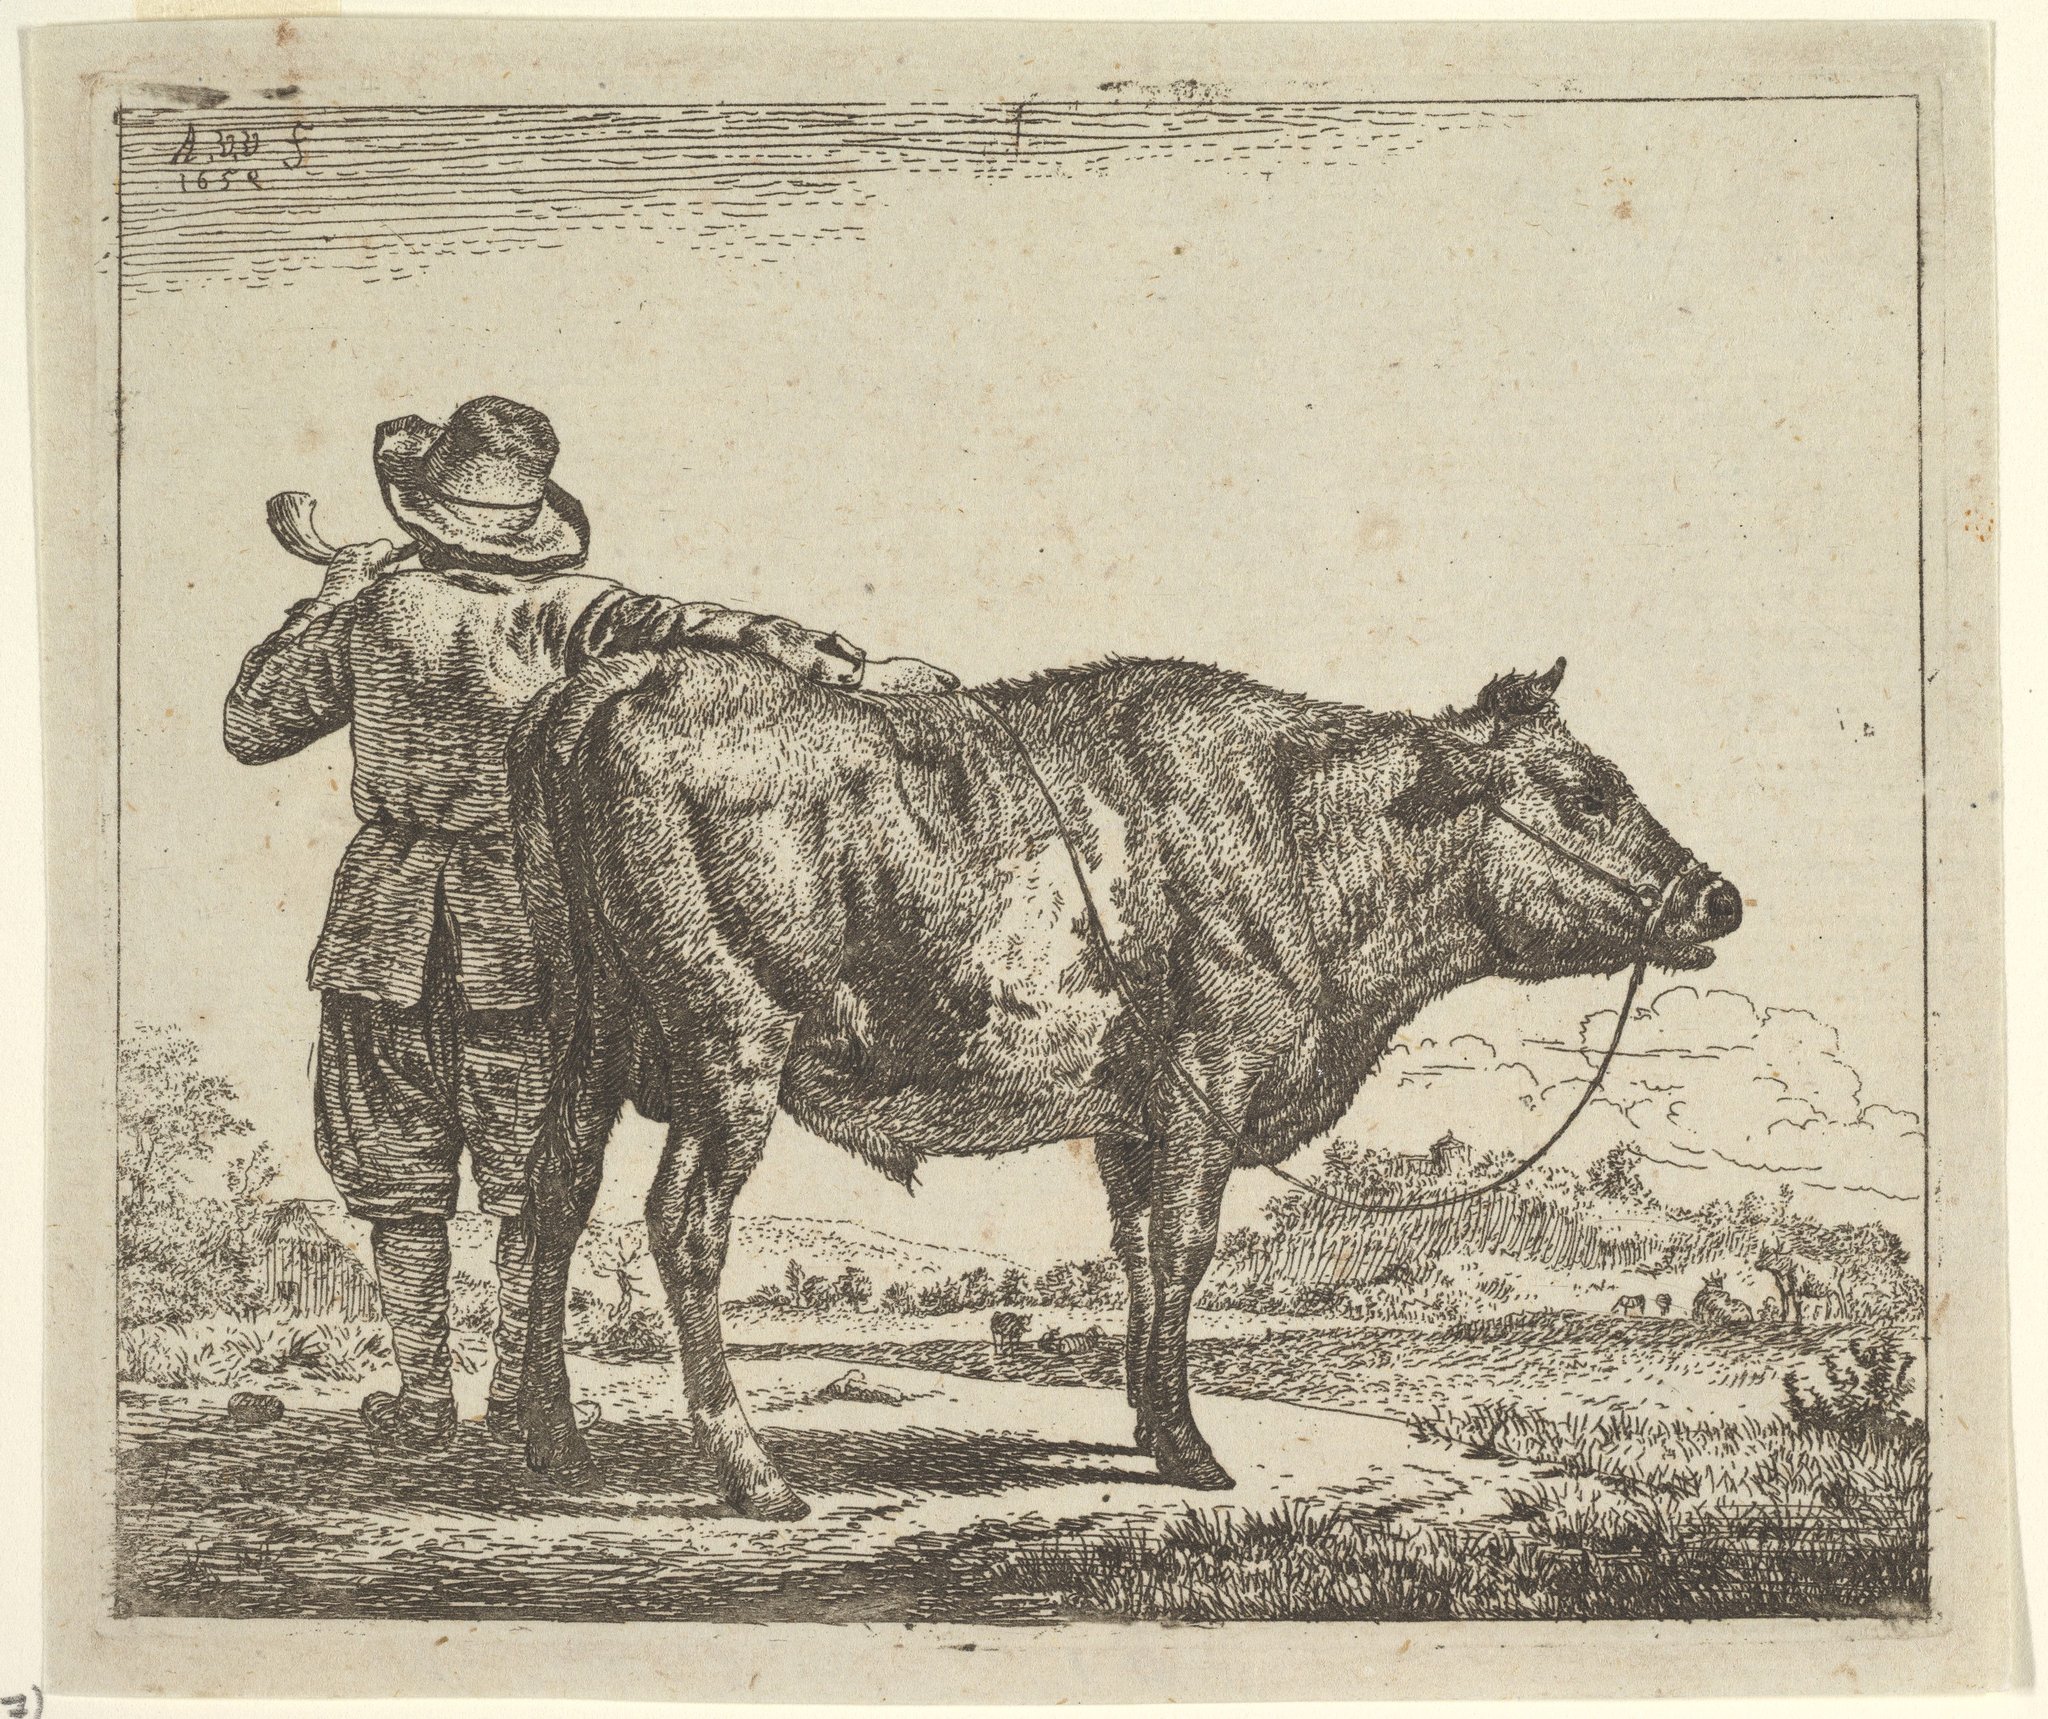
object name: print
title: Young Herdsman with a Bull, plate 1 from "Different Animals"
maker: adriaen van de velde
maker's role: artist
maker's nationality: dutch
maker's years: 1636-1672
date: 1659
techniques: etching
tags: men,bulls